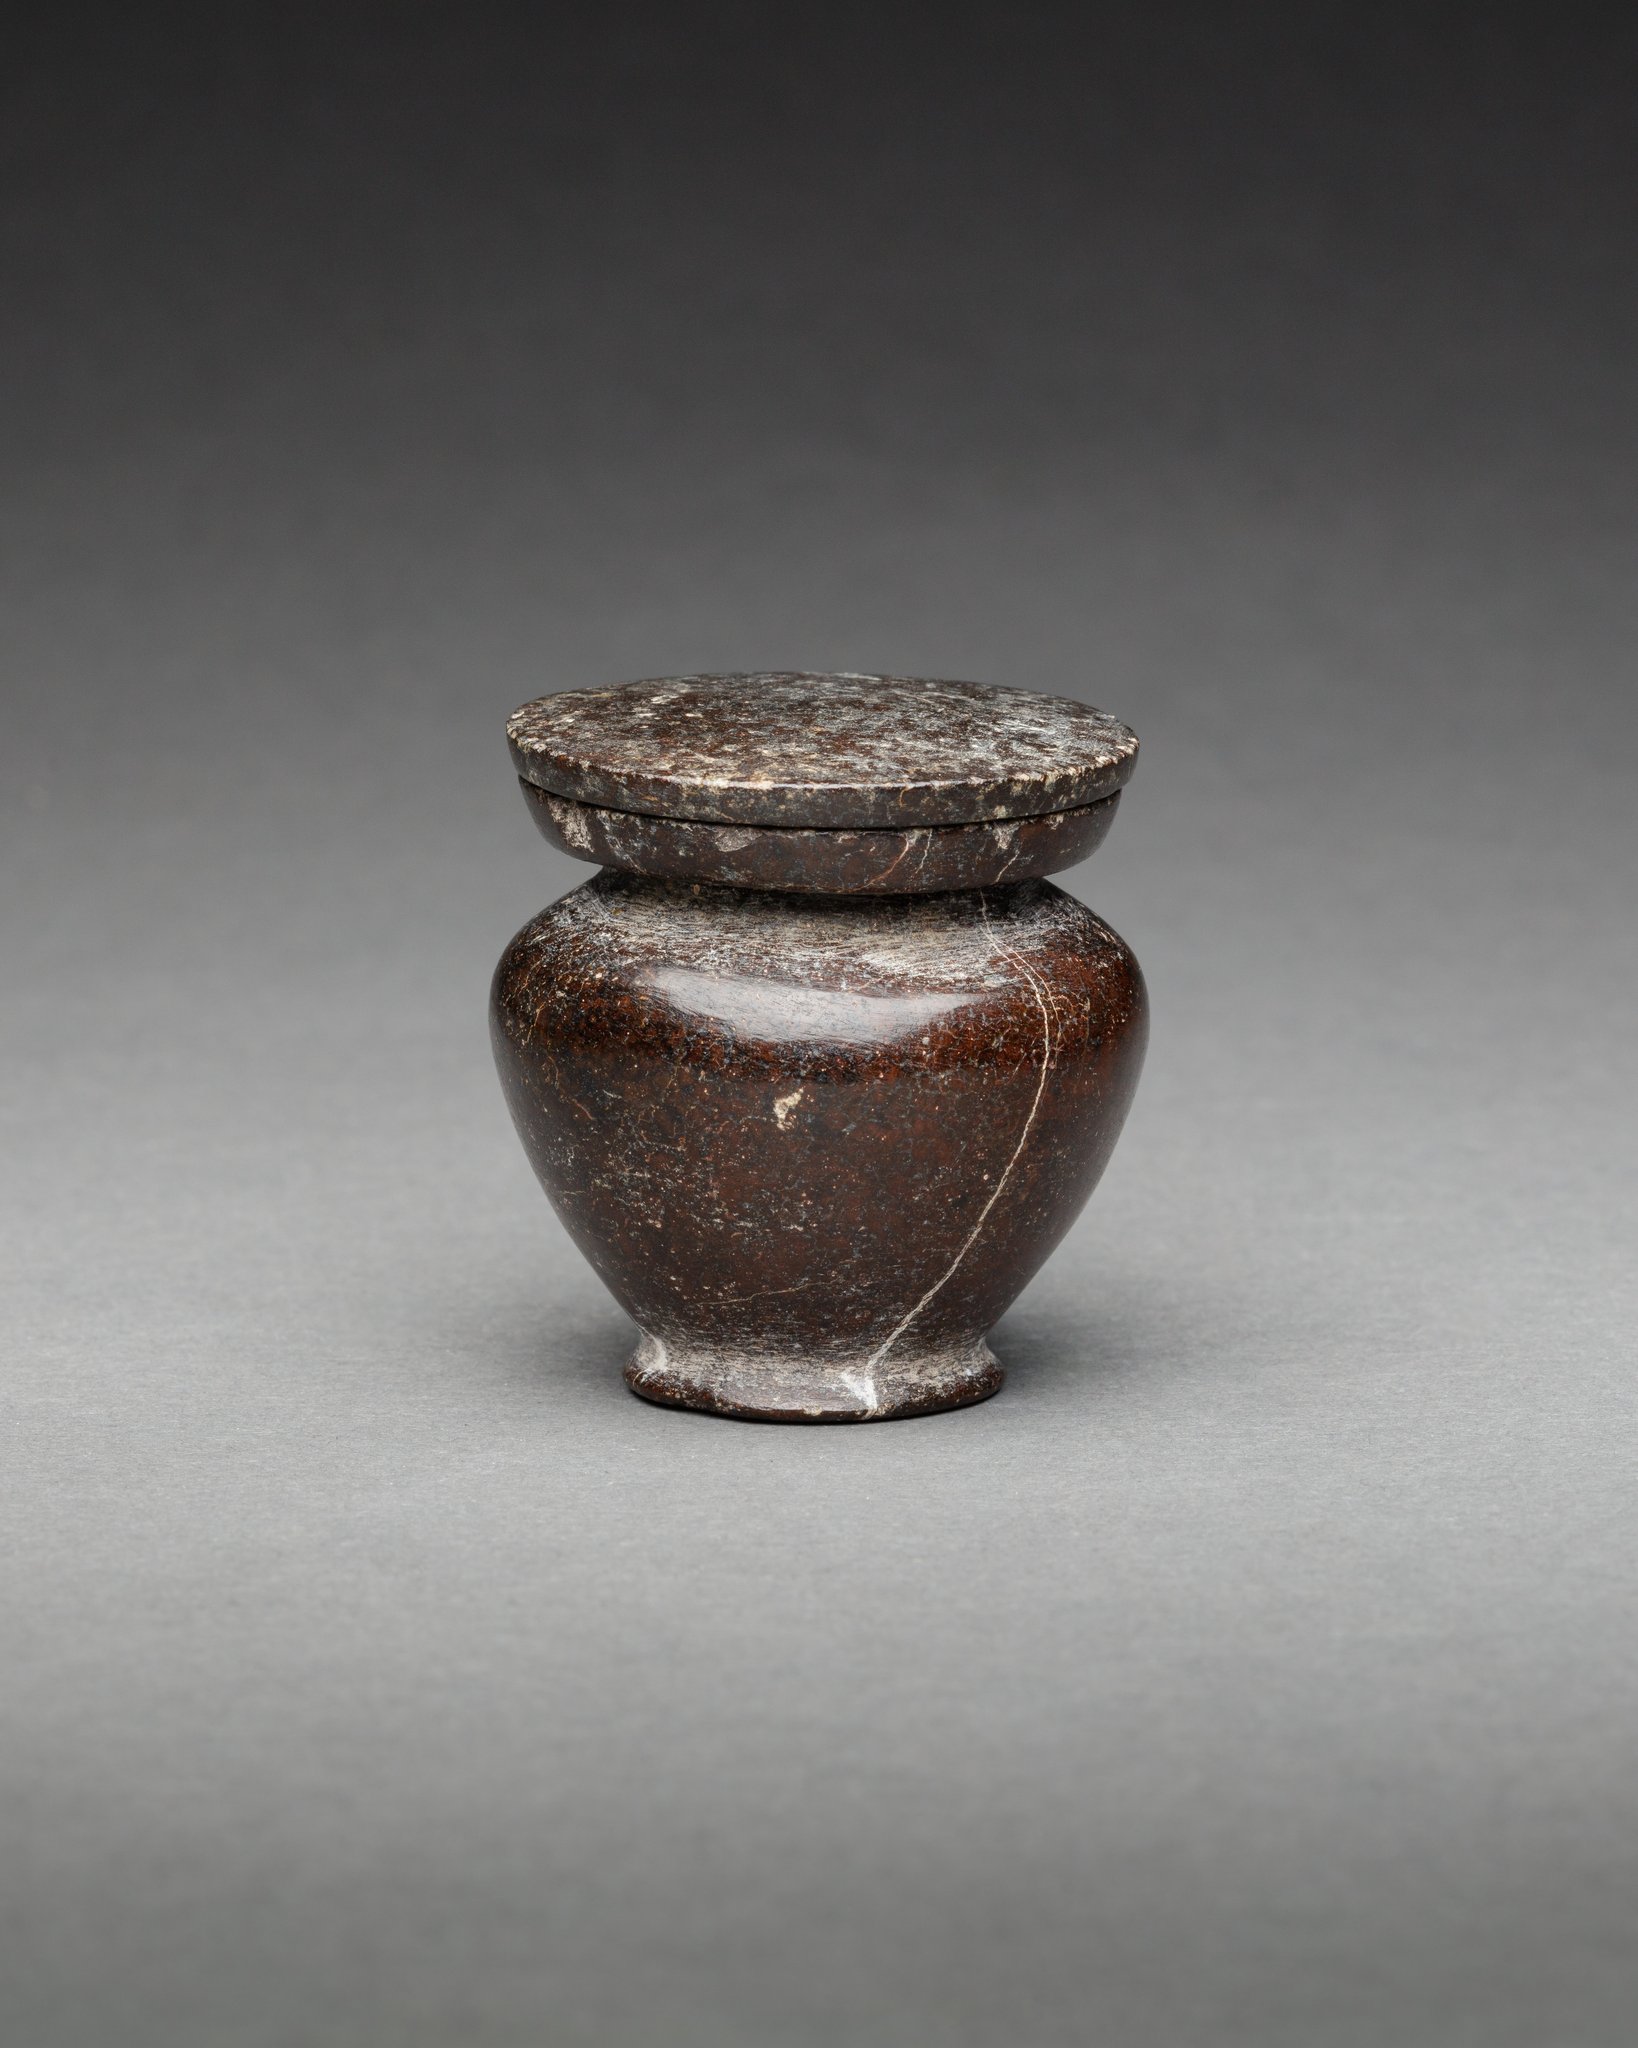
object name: kohl jar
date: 1850-1640 BCE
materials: stone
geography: egypt